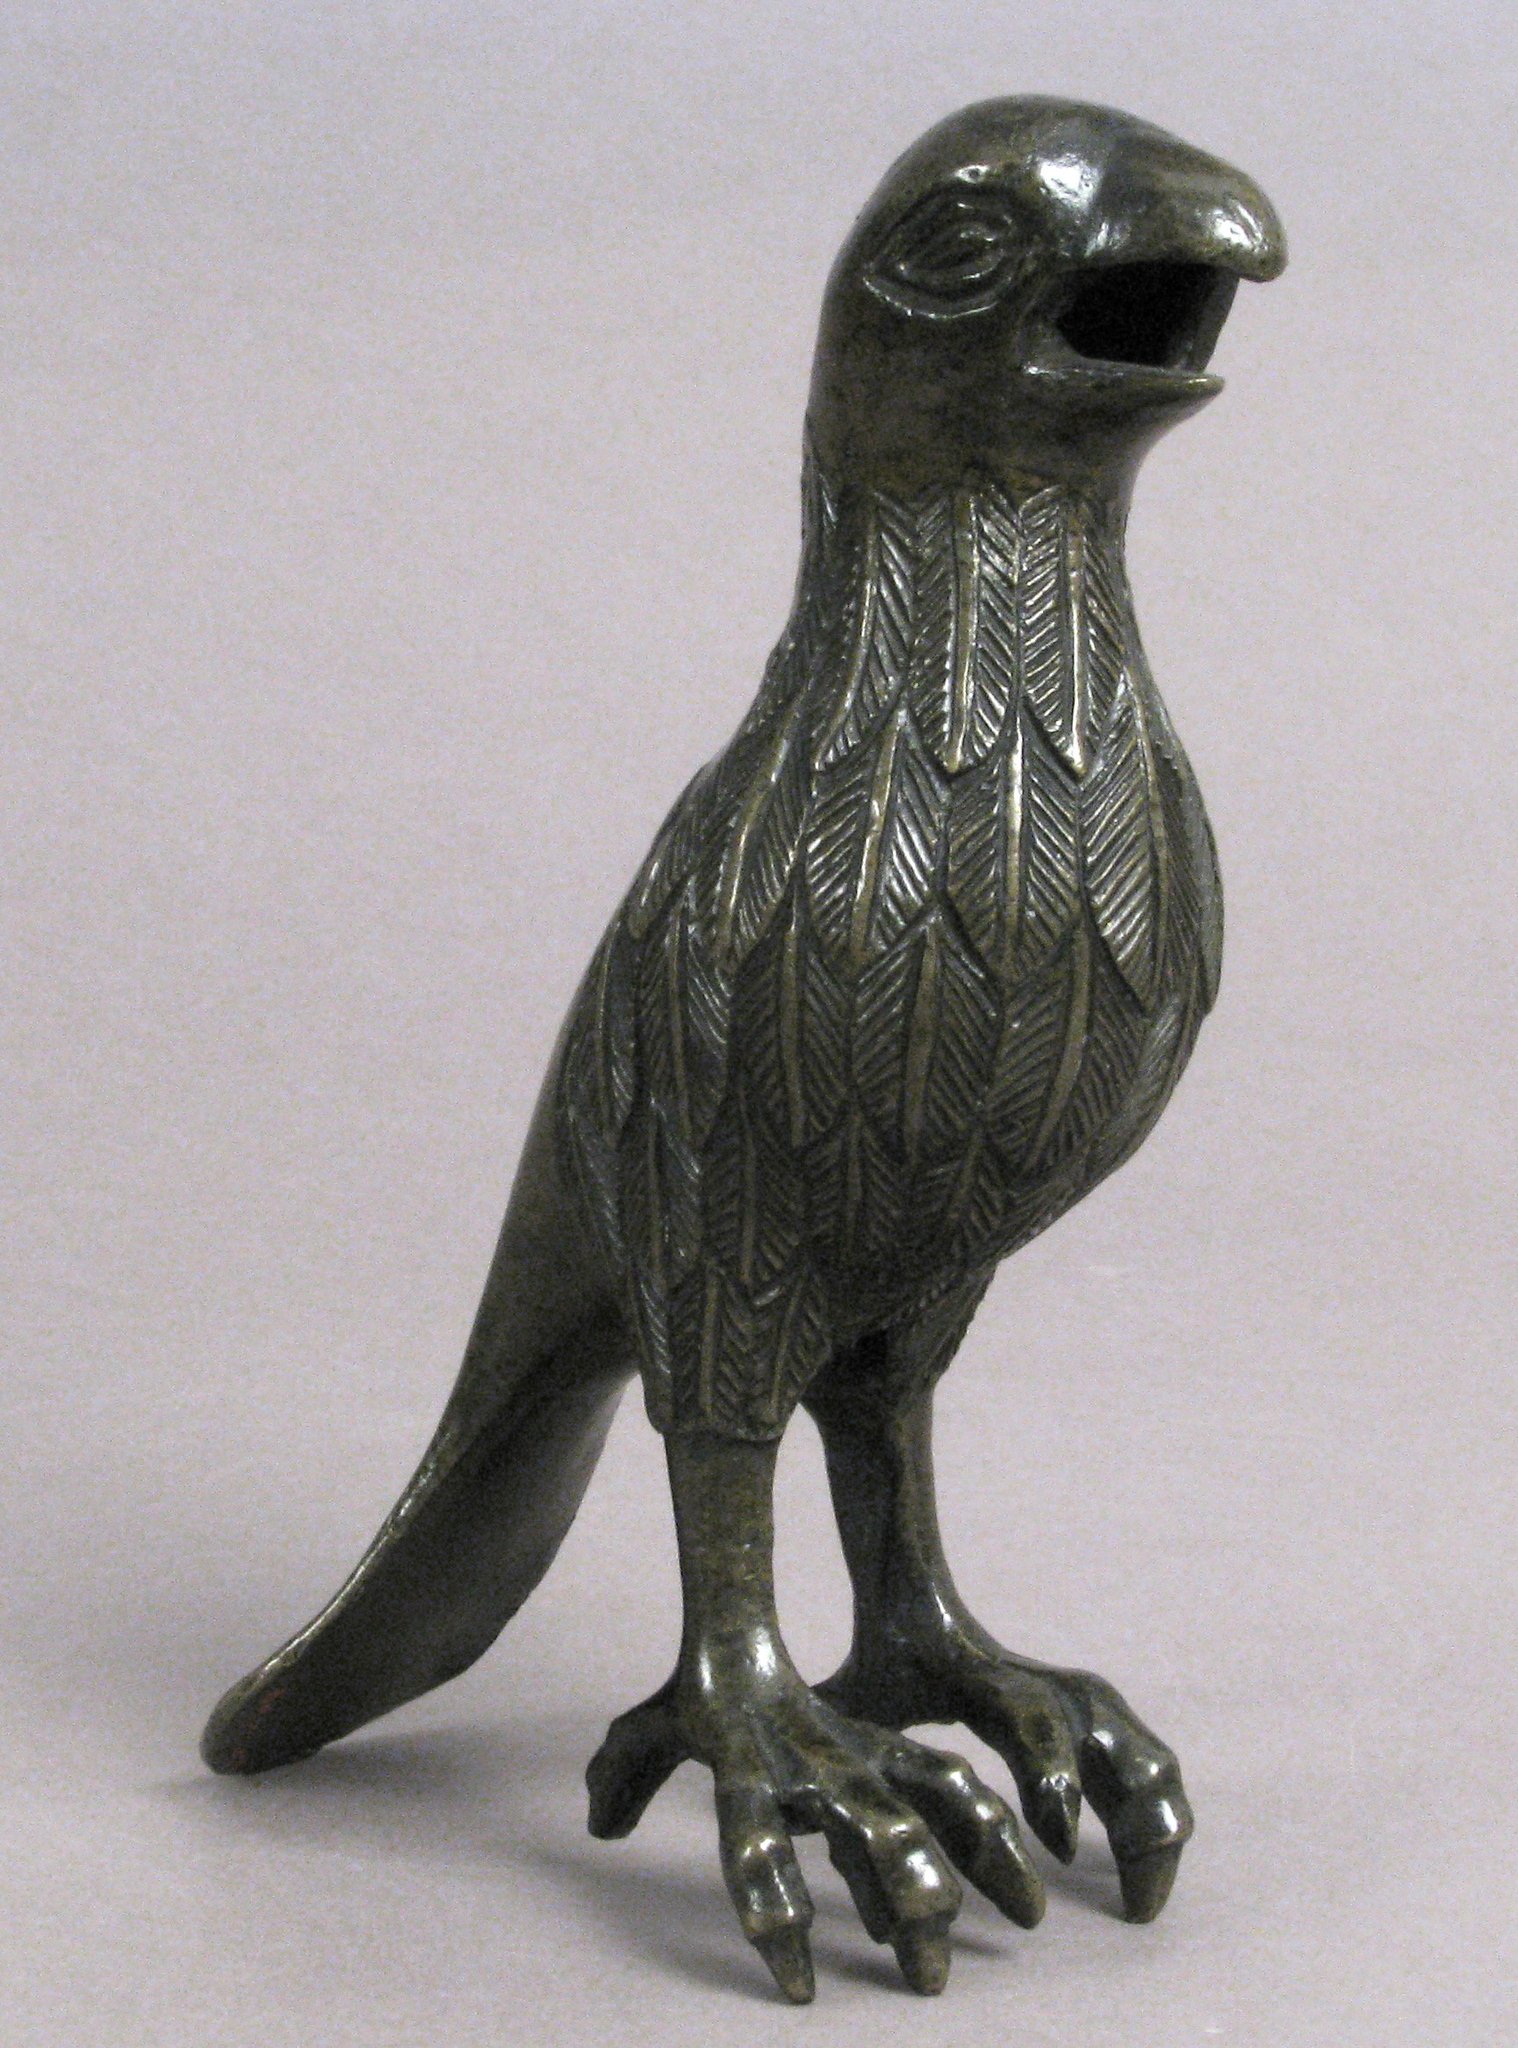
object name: figure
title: Bird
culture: south netherlandish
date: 1401-1500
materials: copper alloy